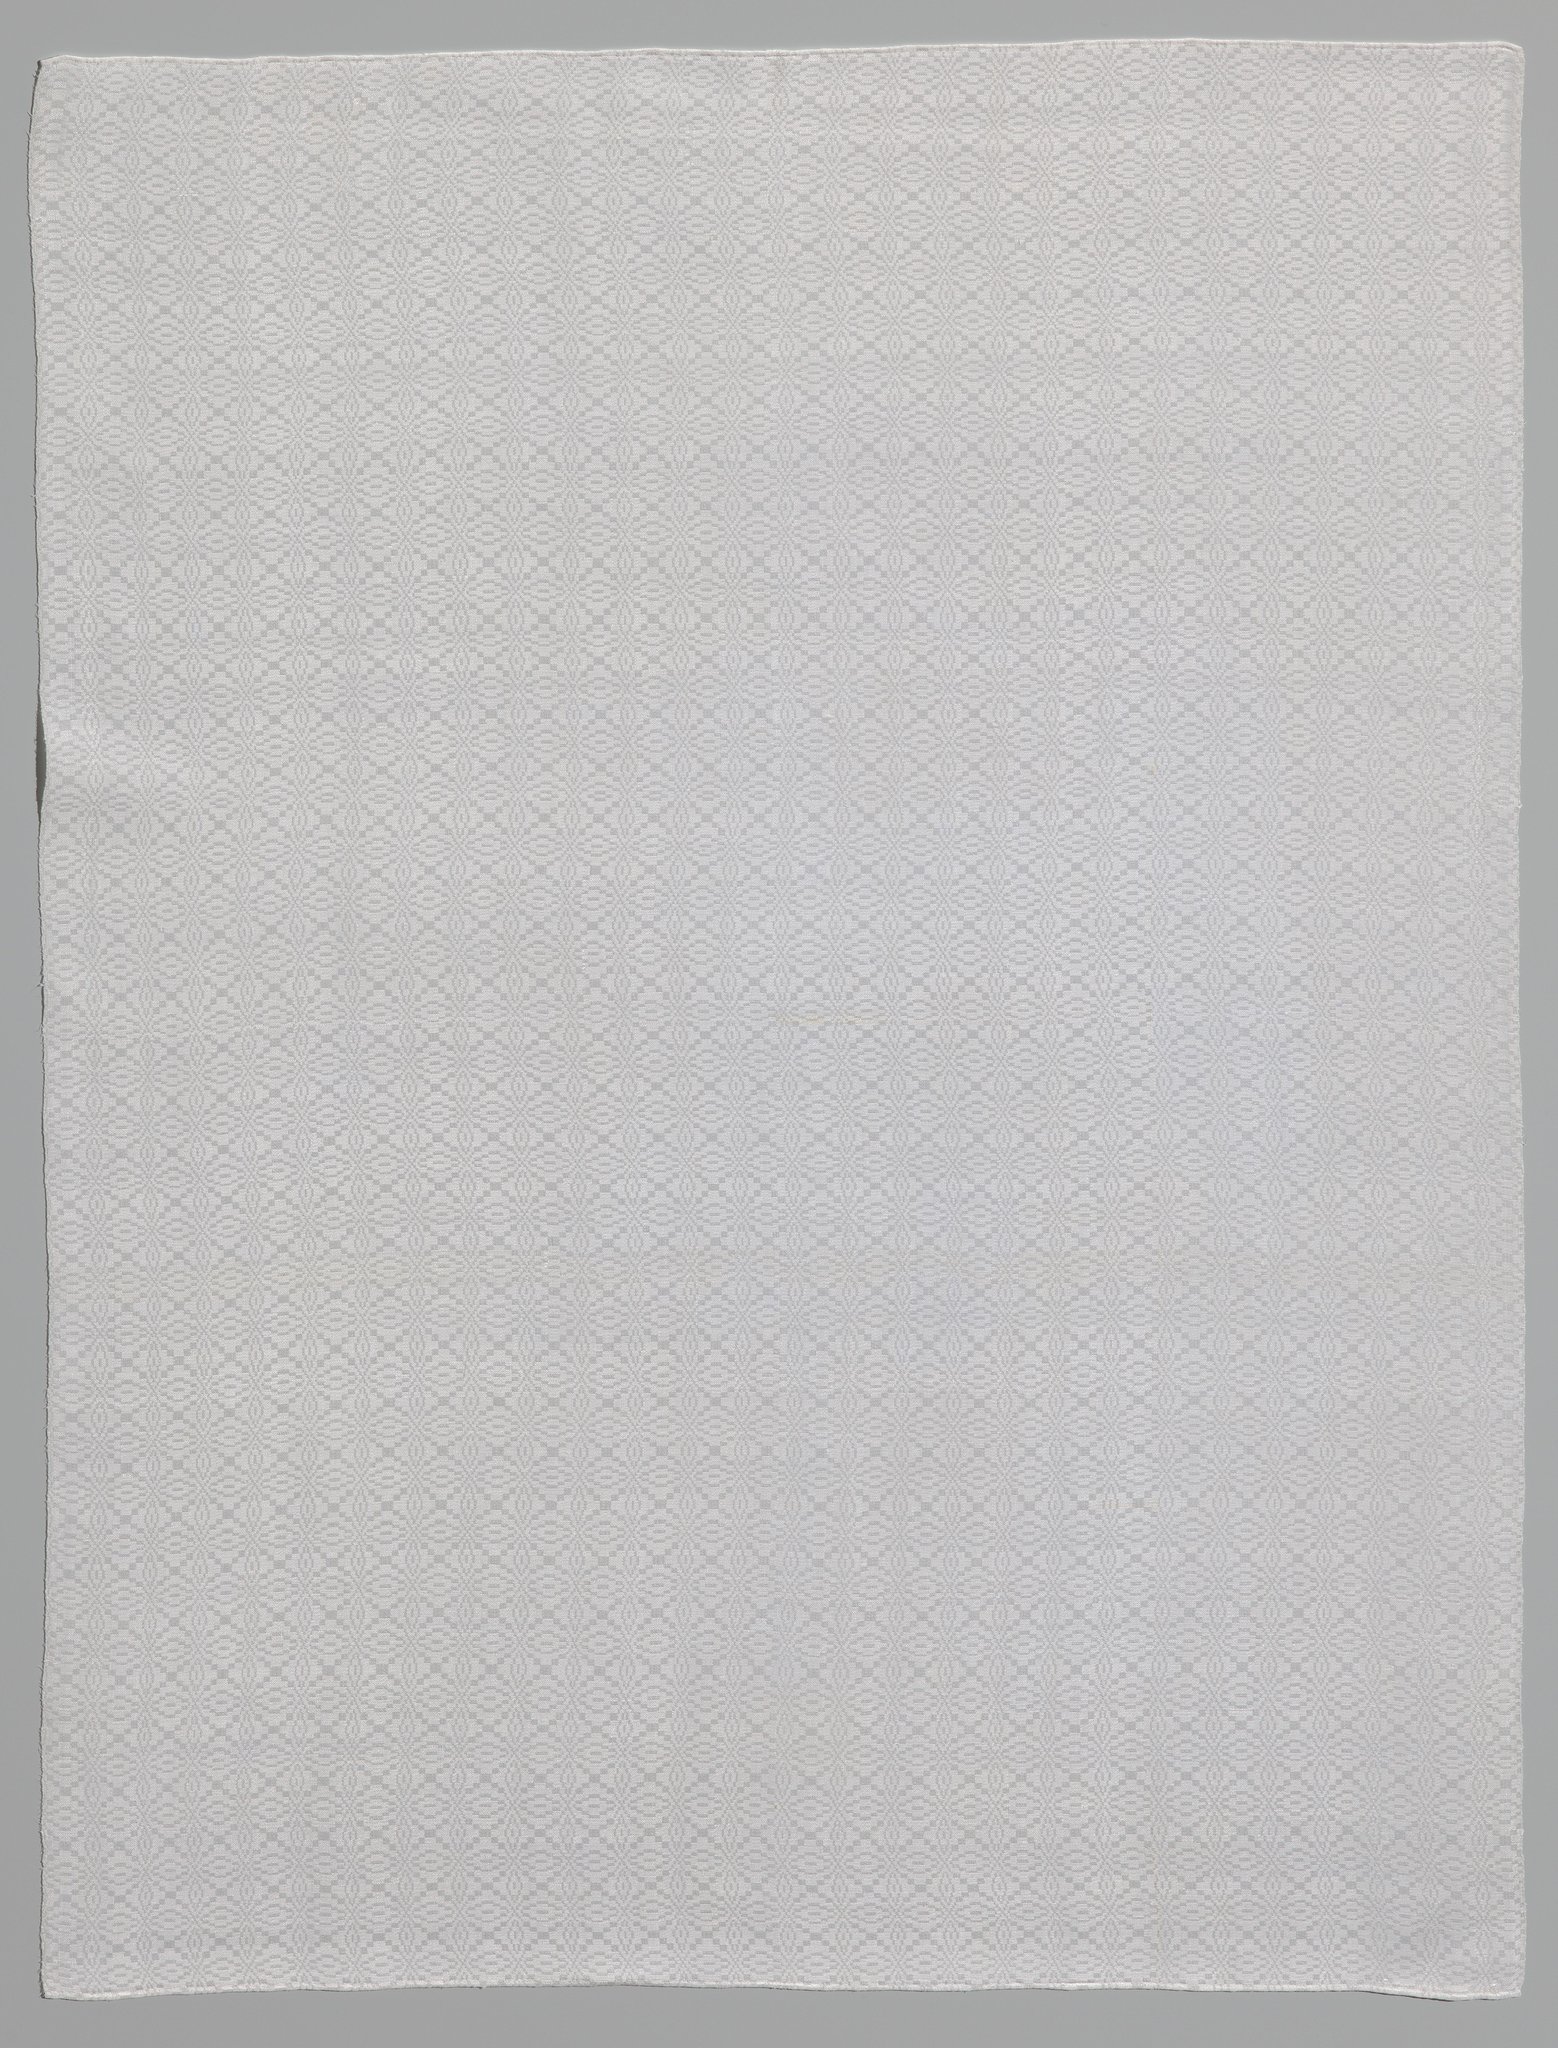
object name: napkin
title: Pellen. Merk: HS12 WH 2oonl.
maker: Anonymous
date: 1600-1699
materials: linen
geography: netherlands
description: Servet van wit linnen met een pellen patroon, merk HS 12 en fraaie grote stop WH 2oonl.